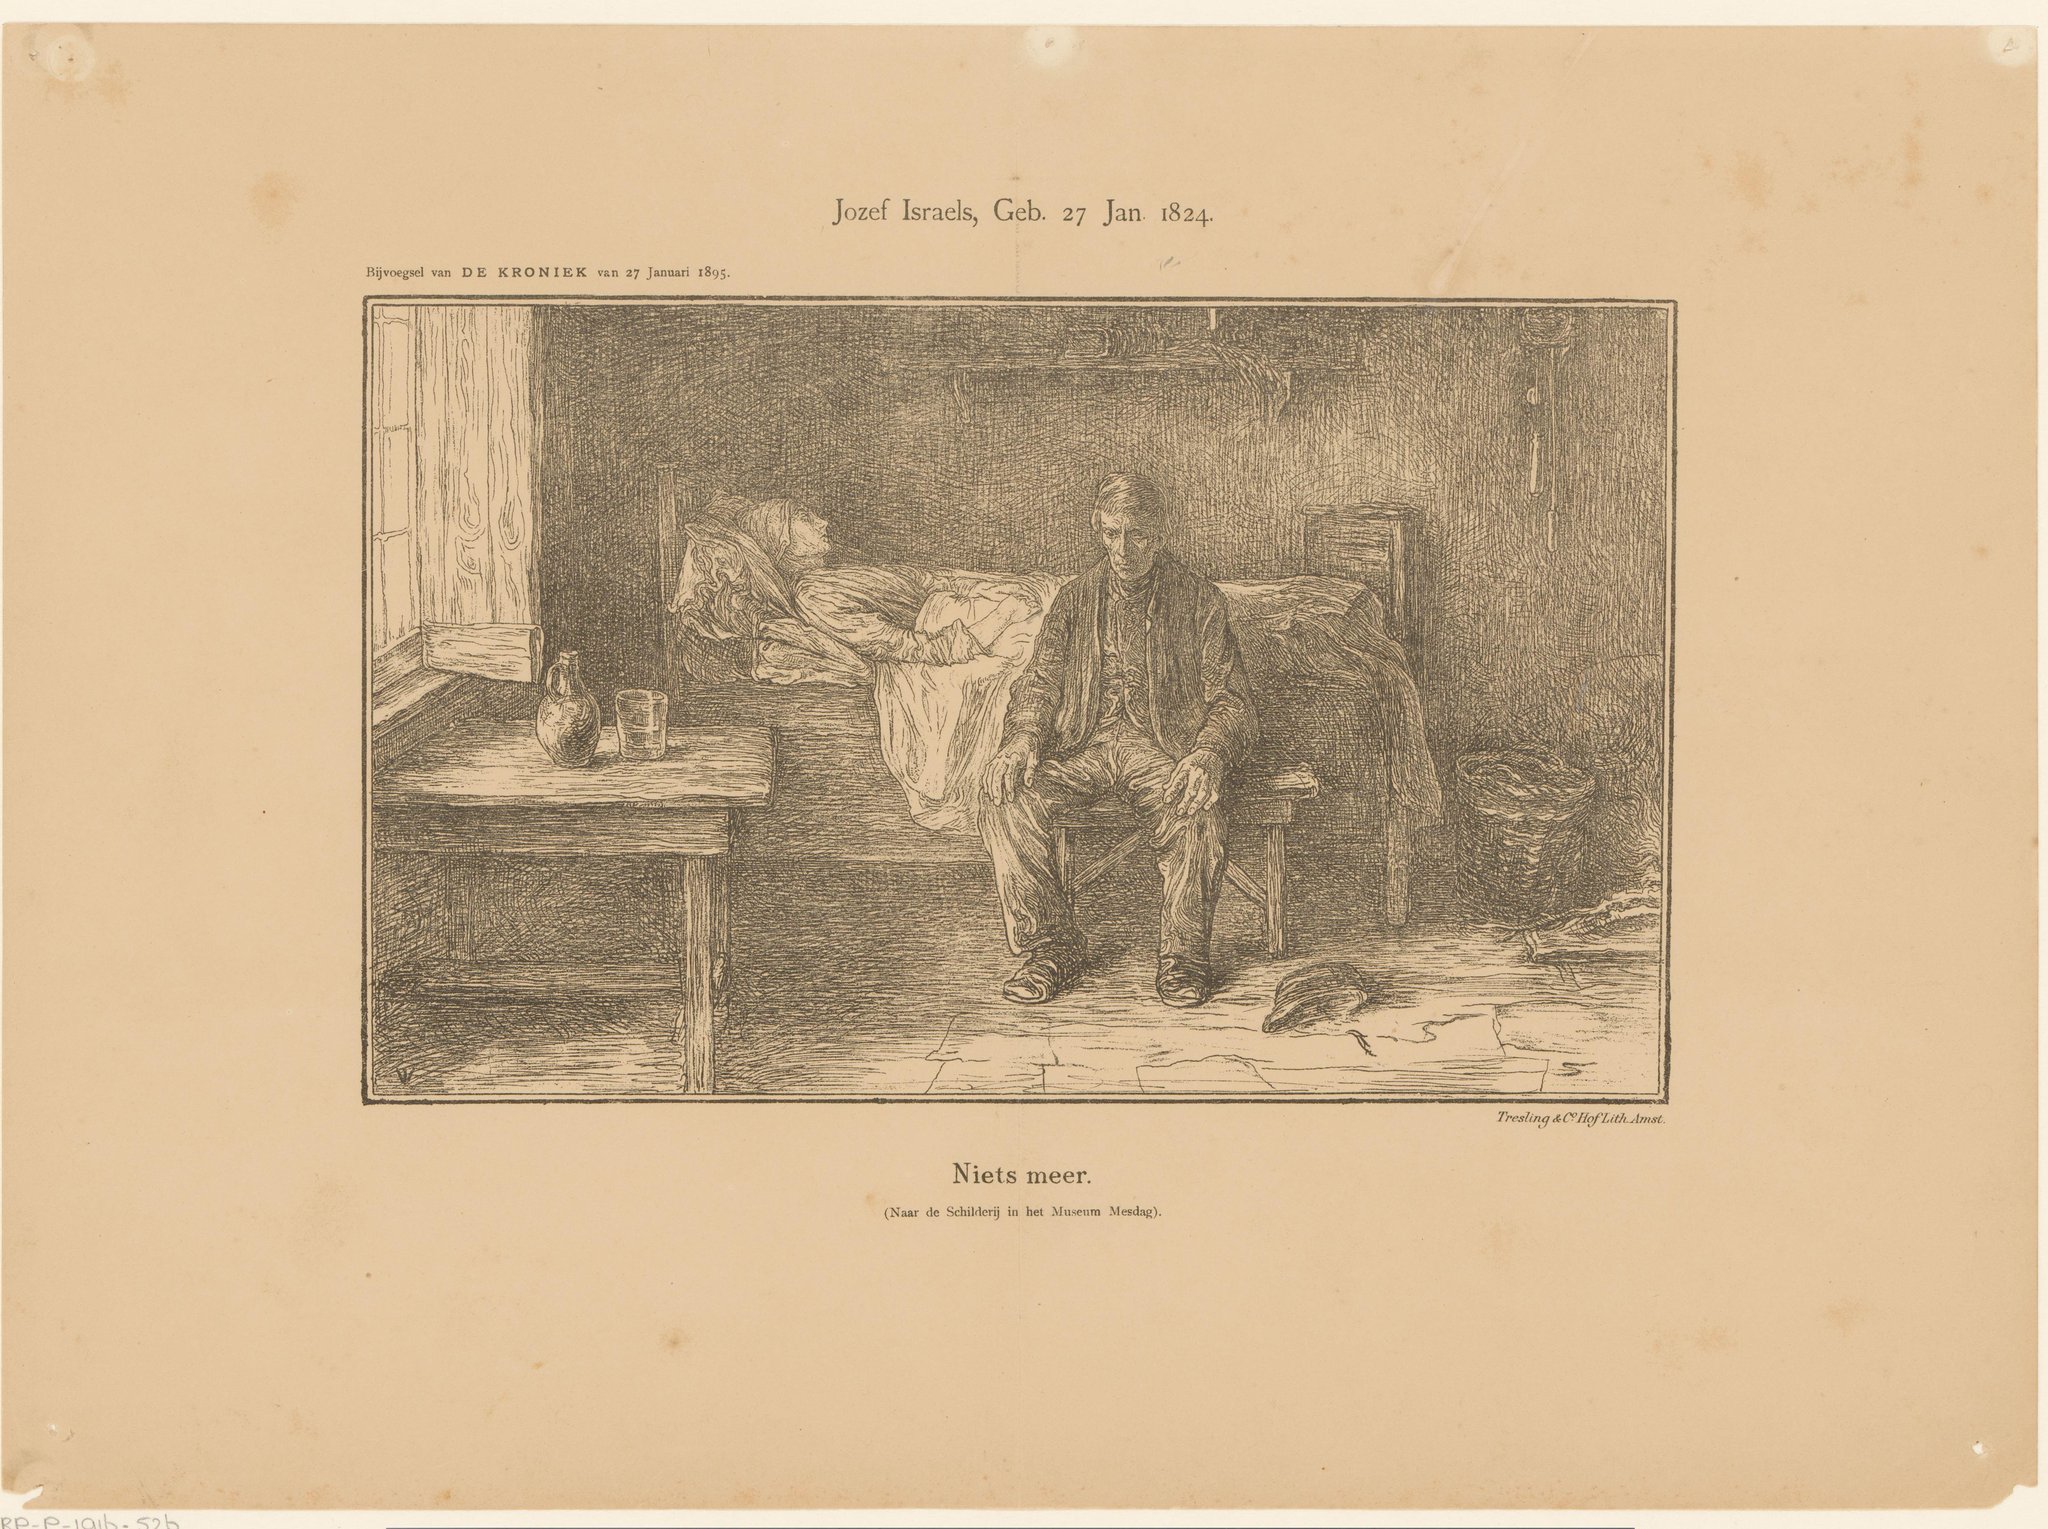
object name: print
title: Alleen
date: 1895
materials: paper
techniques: lithograph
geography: amsterdam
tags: deathbed, mourning the dead, bedroom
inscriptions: collector's mark: Lugt 2228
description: Prent uit het bijvoegsel van: De Kroniek 1 (1895), 27 januari 1895. Naar Alleen (1880-1881) van Jozef Israëls in De Mesdag Collectie te Den Haag.